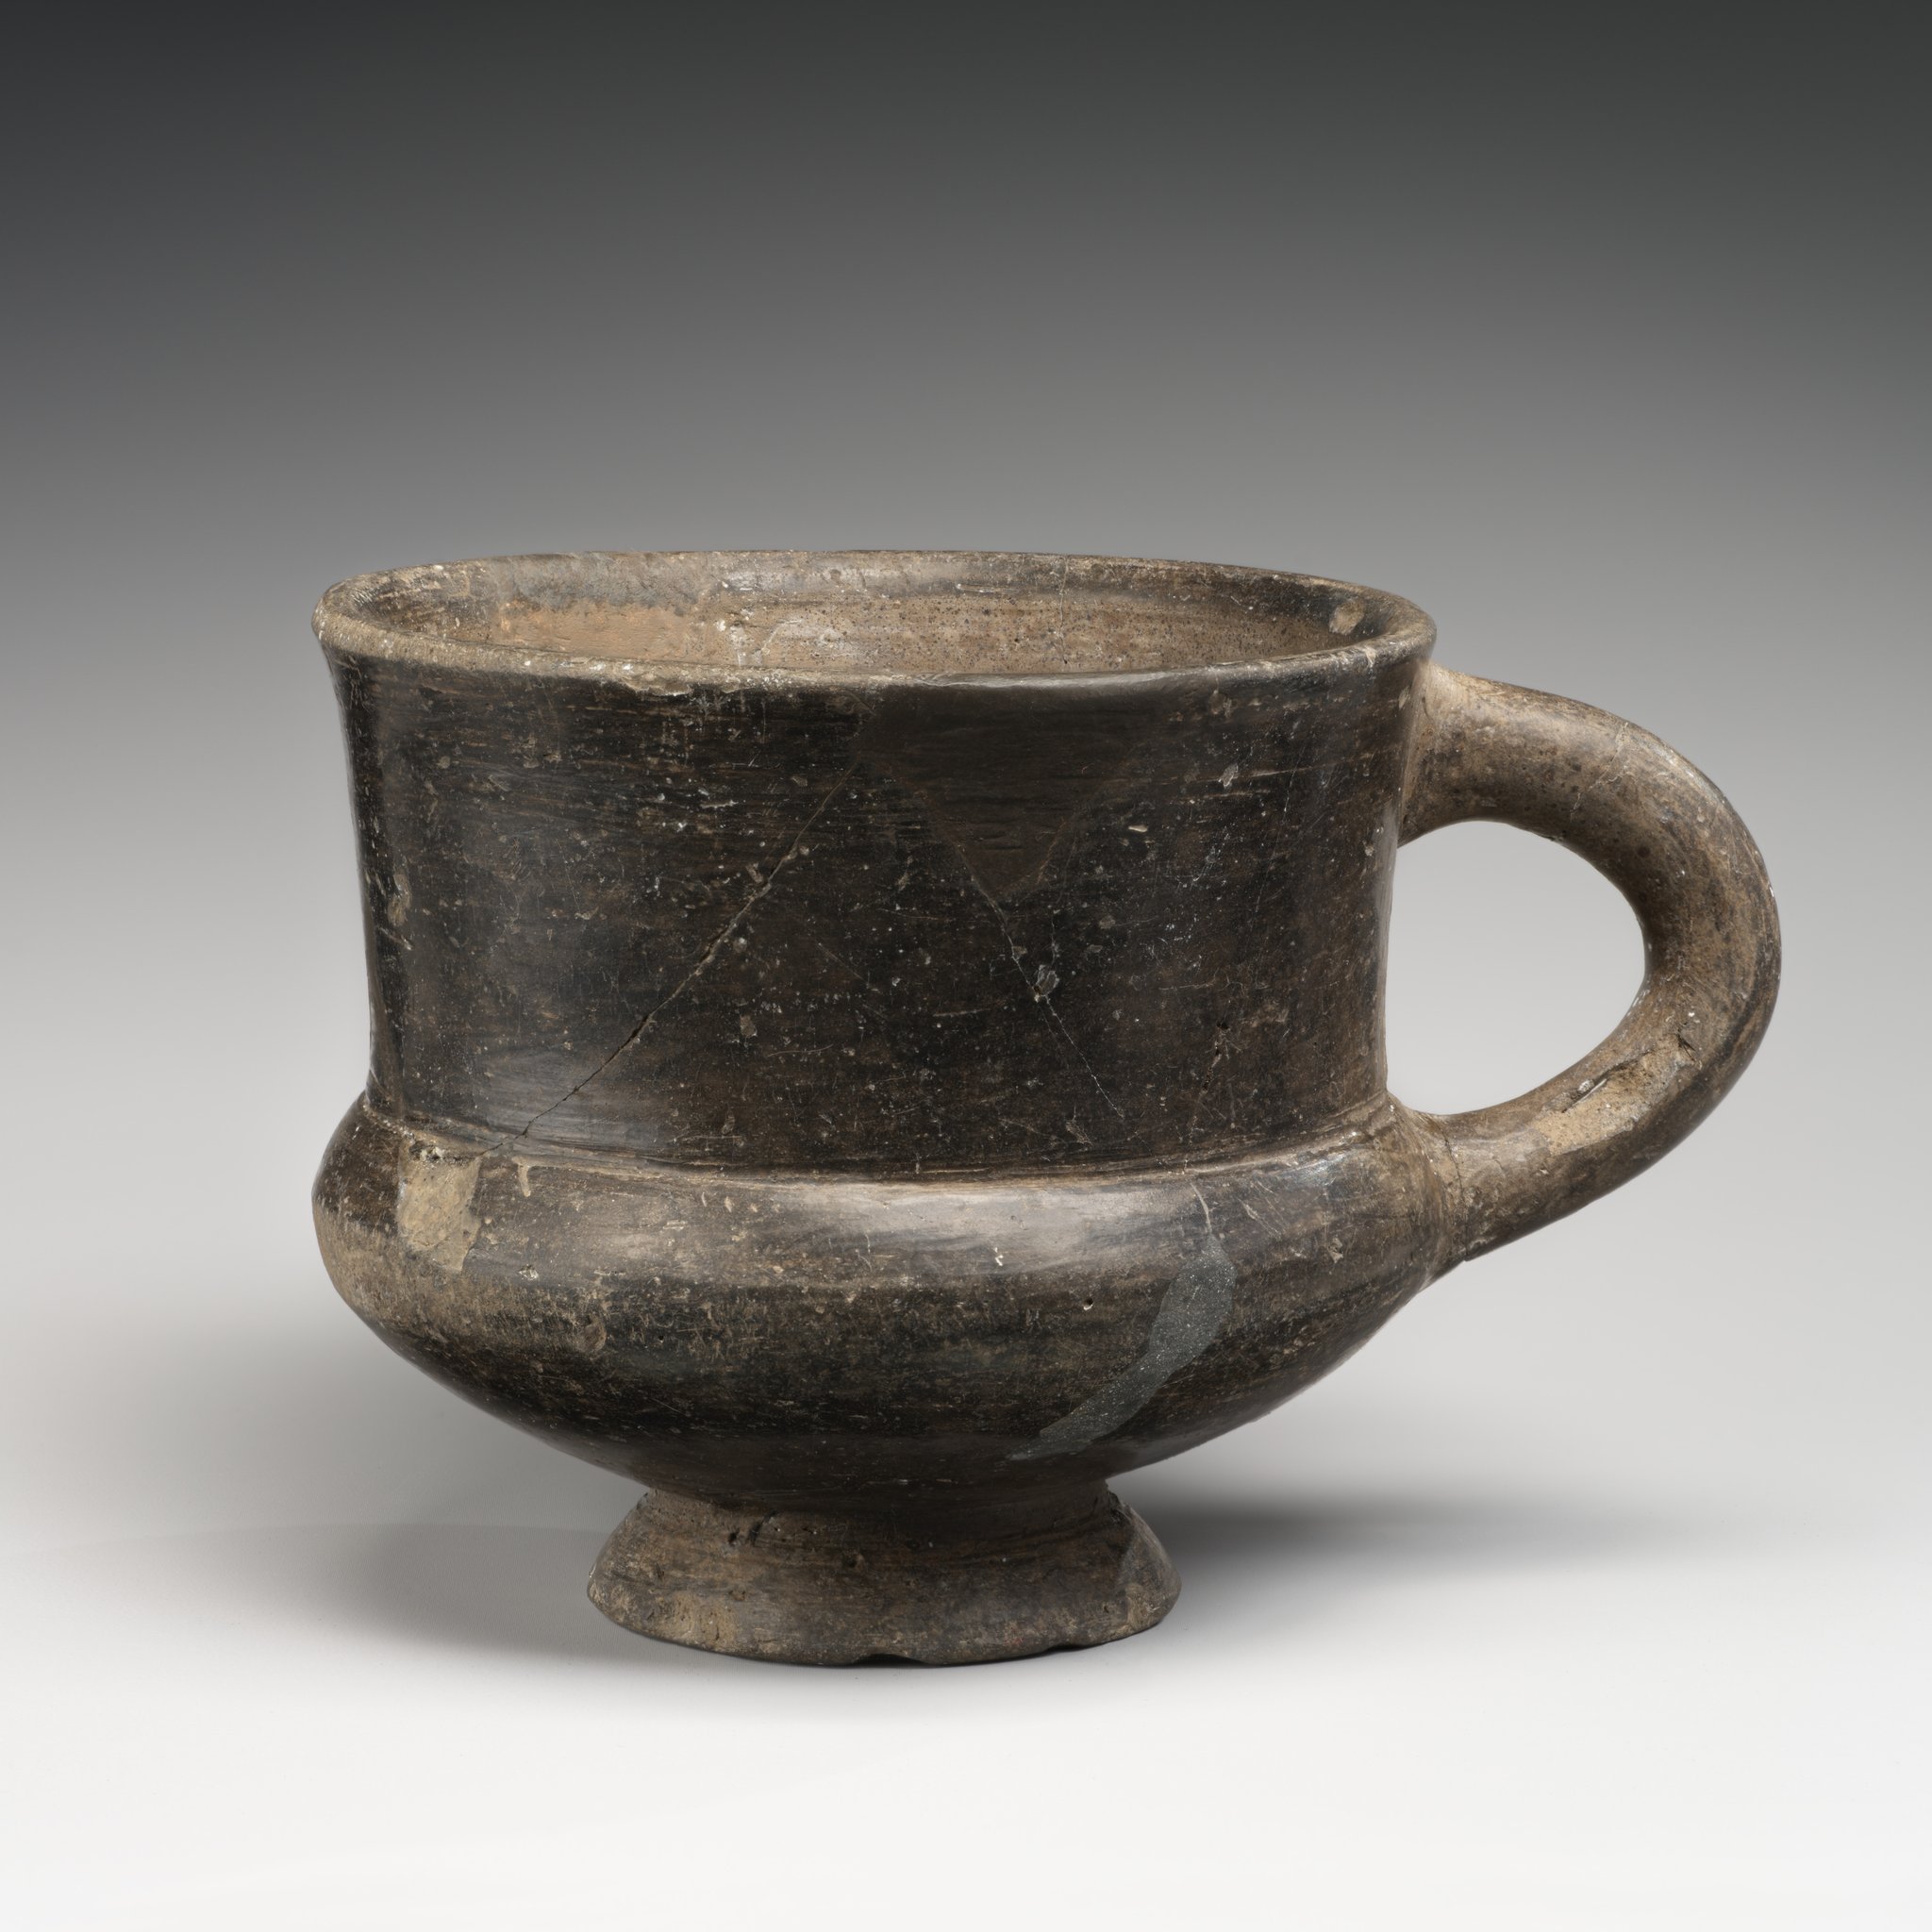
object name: cup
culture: iranian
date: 900-801 BCE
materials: ceramic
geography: iran